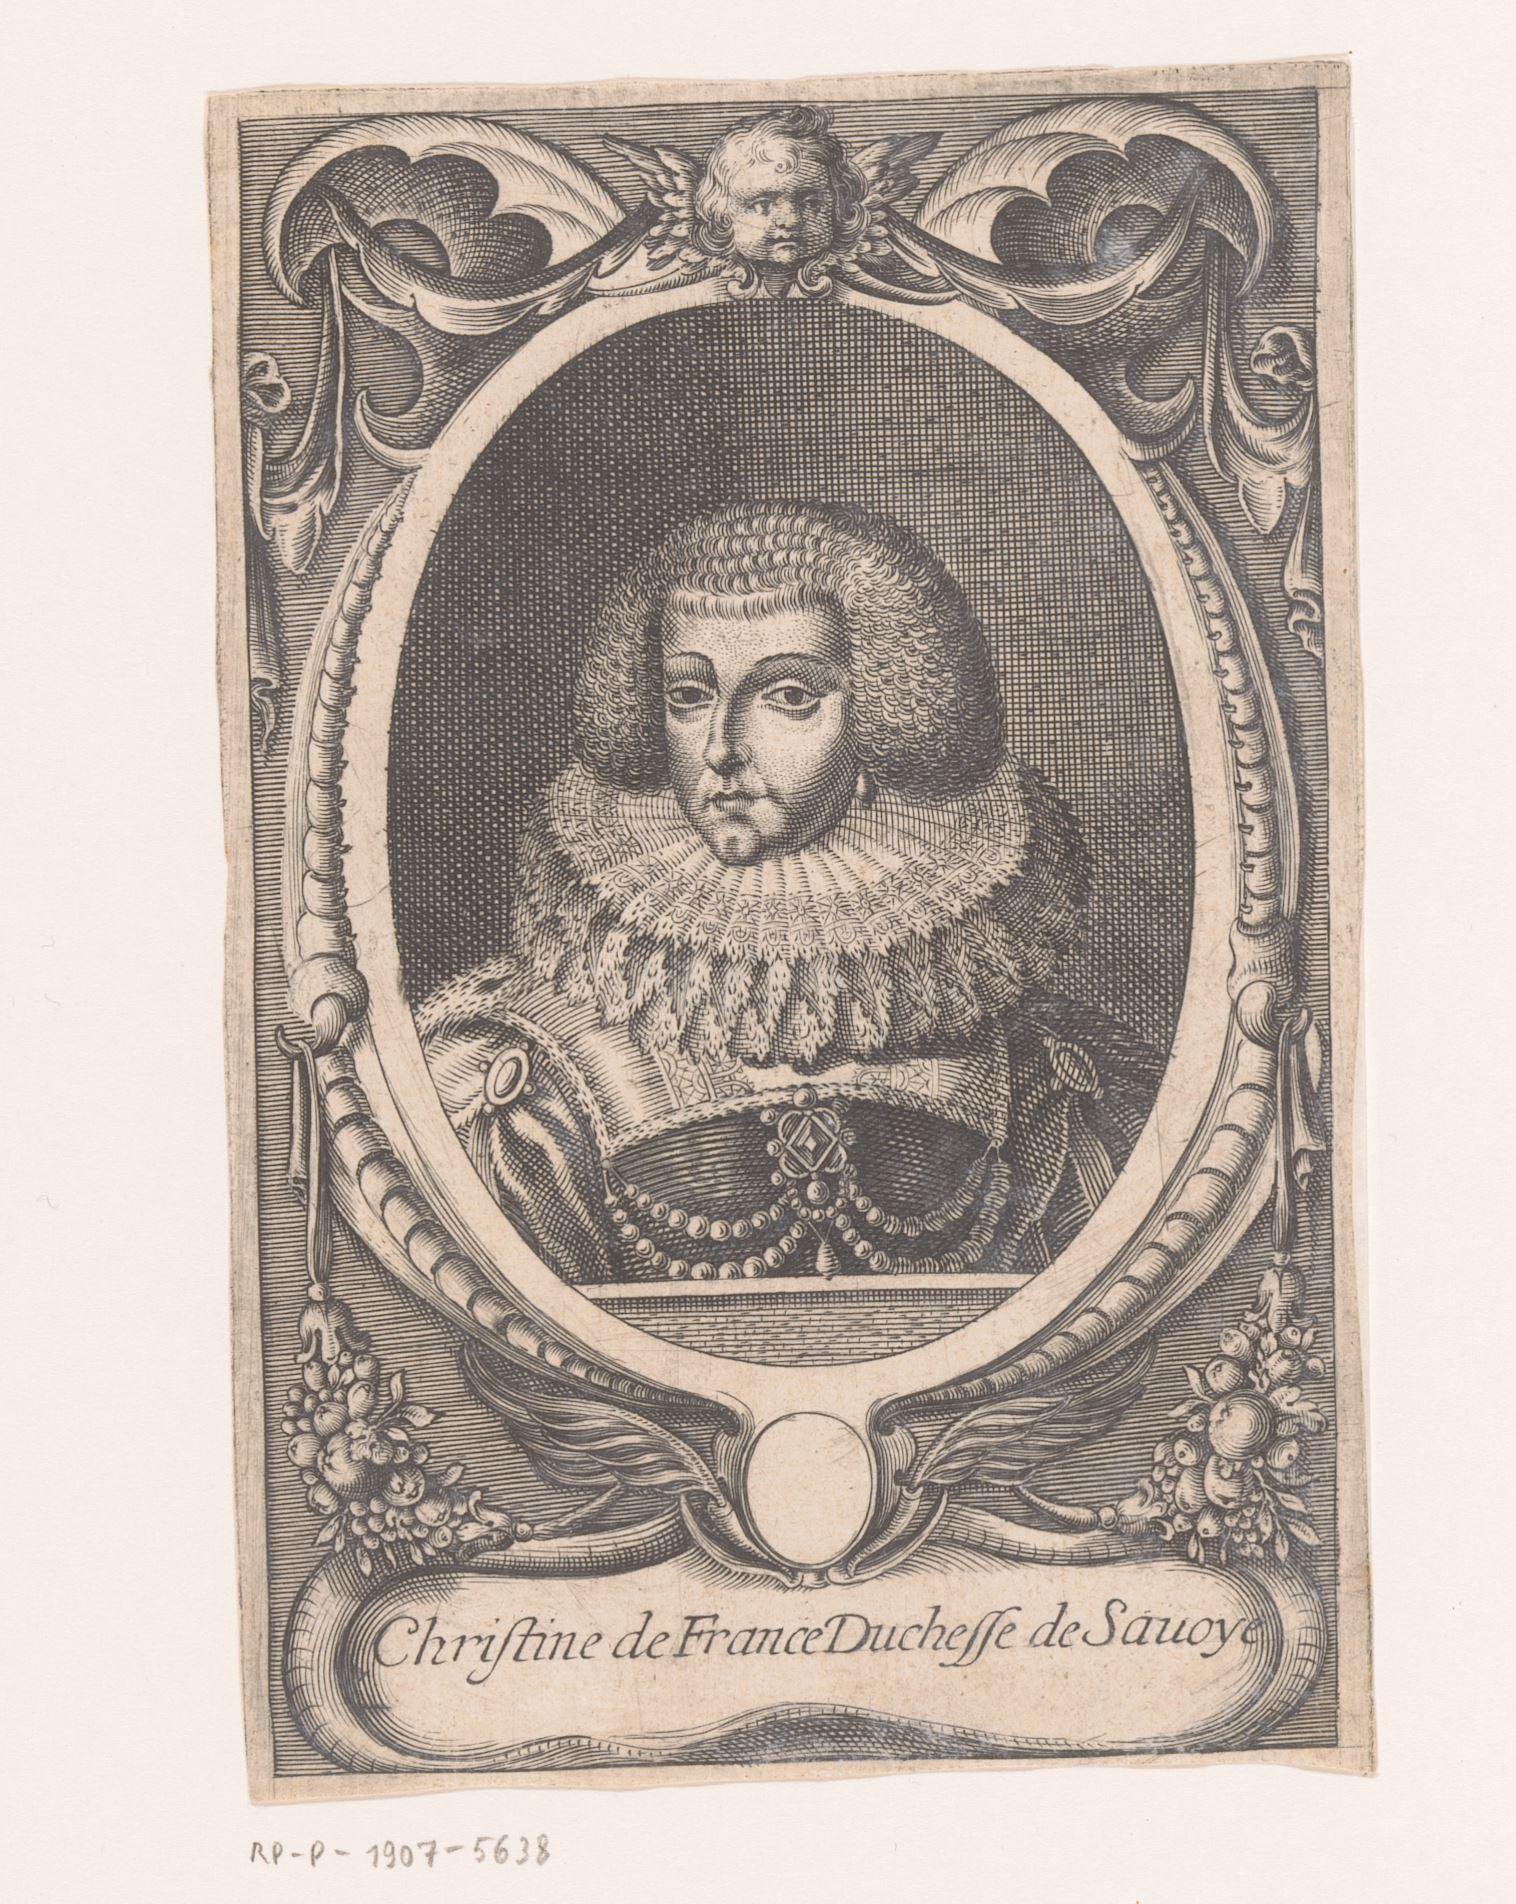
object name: print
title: Portret van Christina van Frankrijk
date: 1621-1668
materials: paper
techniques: engraving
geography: paris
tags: historical persons - bb - woman, nobility and patriciate; chivalry, knighthood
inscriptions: collector's mark: Lugt 2228